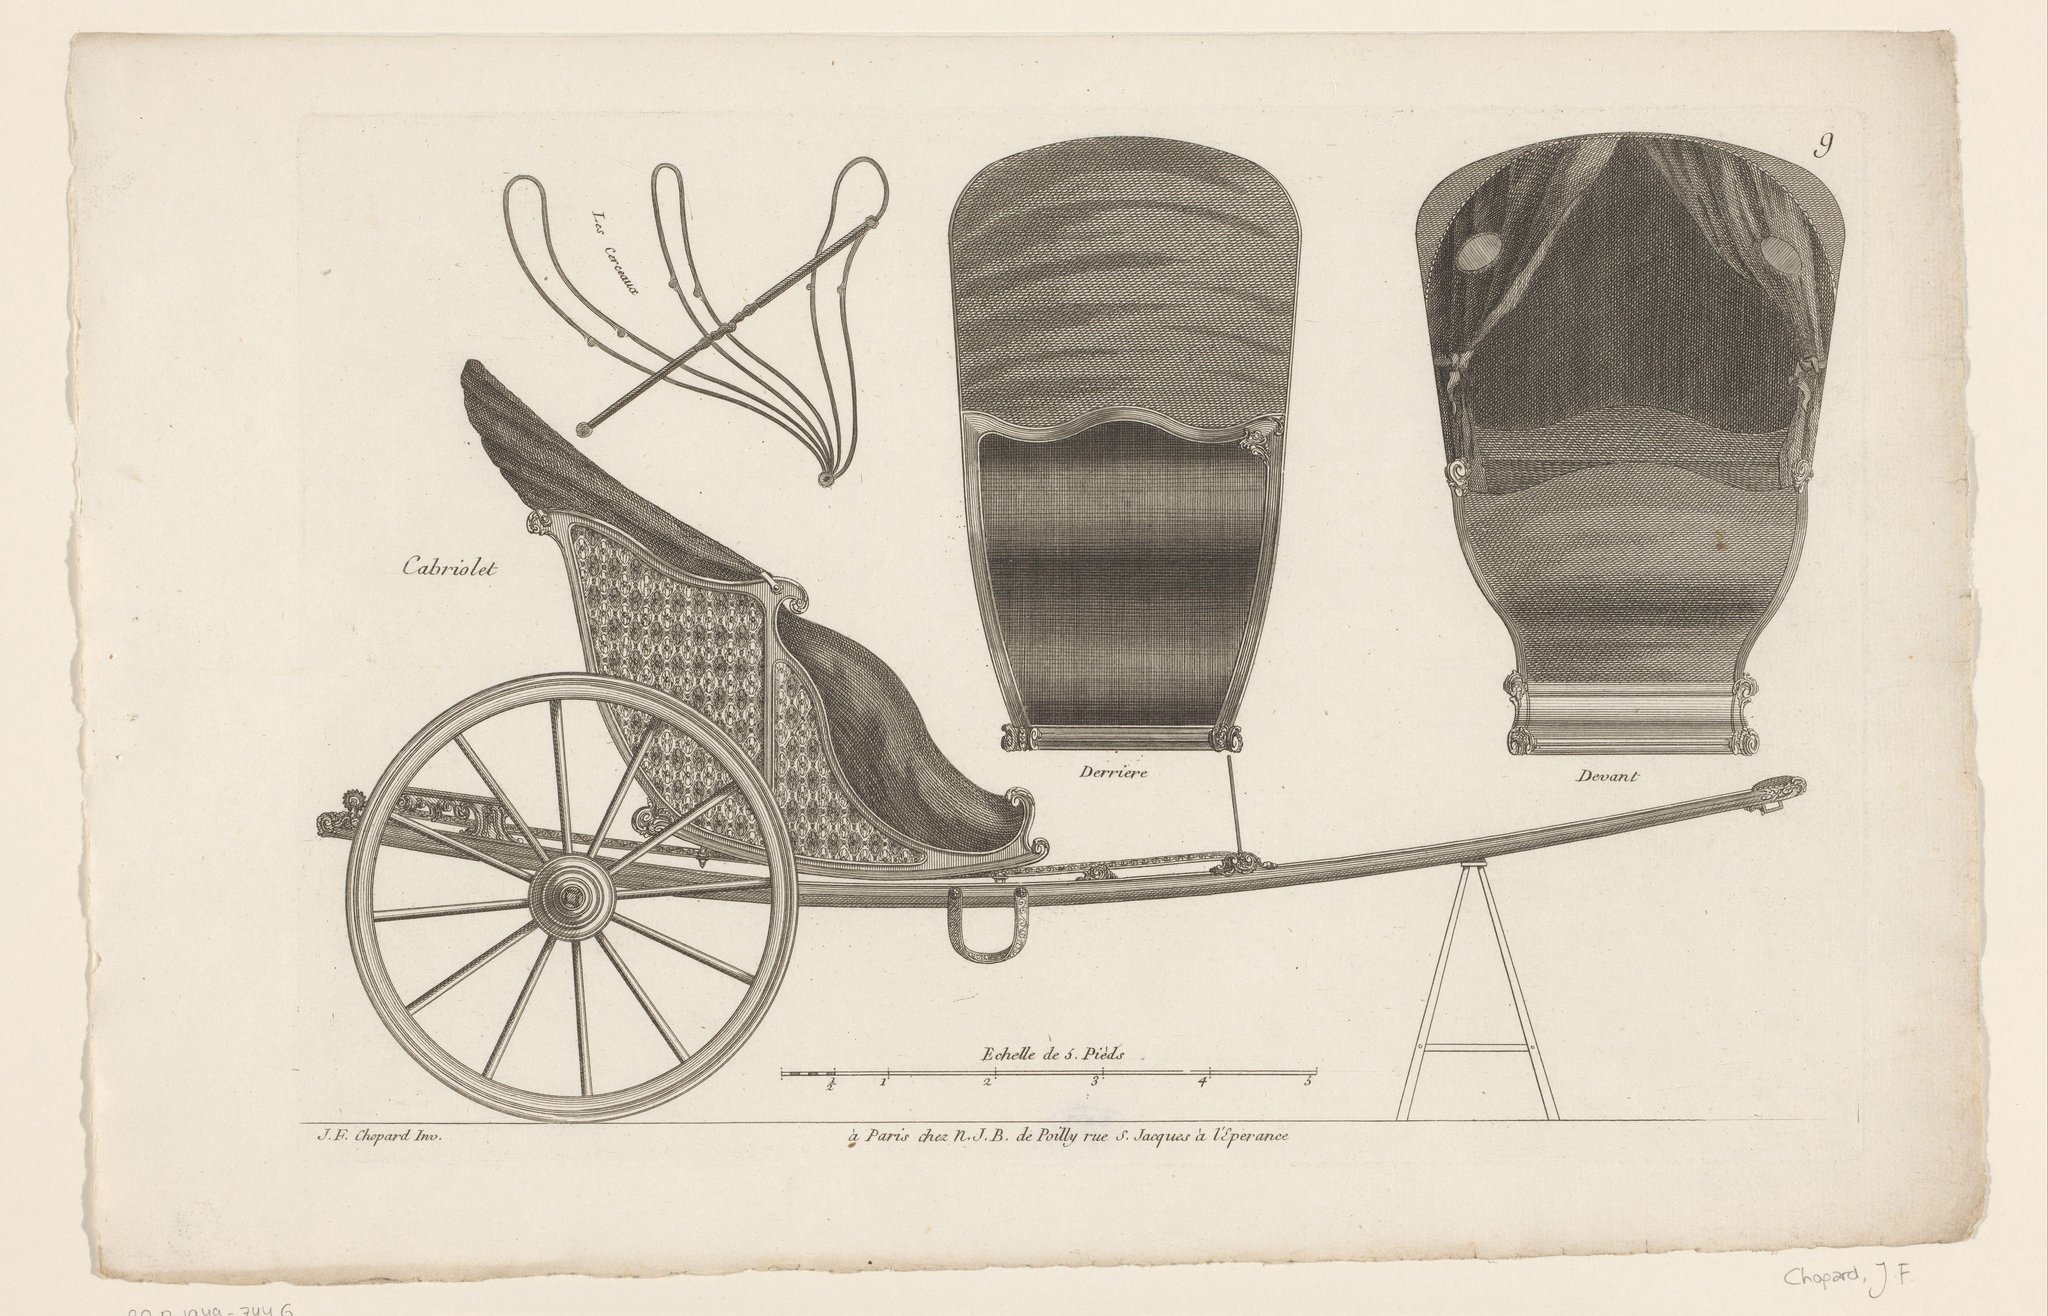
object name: print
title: Modèles de voitures Louis XV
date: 1740-1758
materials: paper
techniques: engraving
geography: paris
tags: four-wheeled, animal-drawn vehicle, e.g.: cab, carriage, coach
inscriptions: collector's mark: Lugt 2228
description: Cabriolet op twee wielen met opklapbare overkapping. Een cabriolet is een open rijtuig.